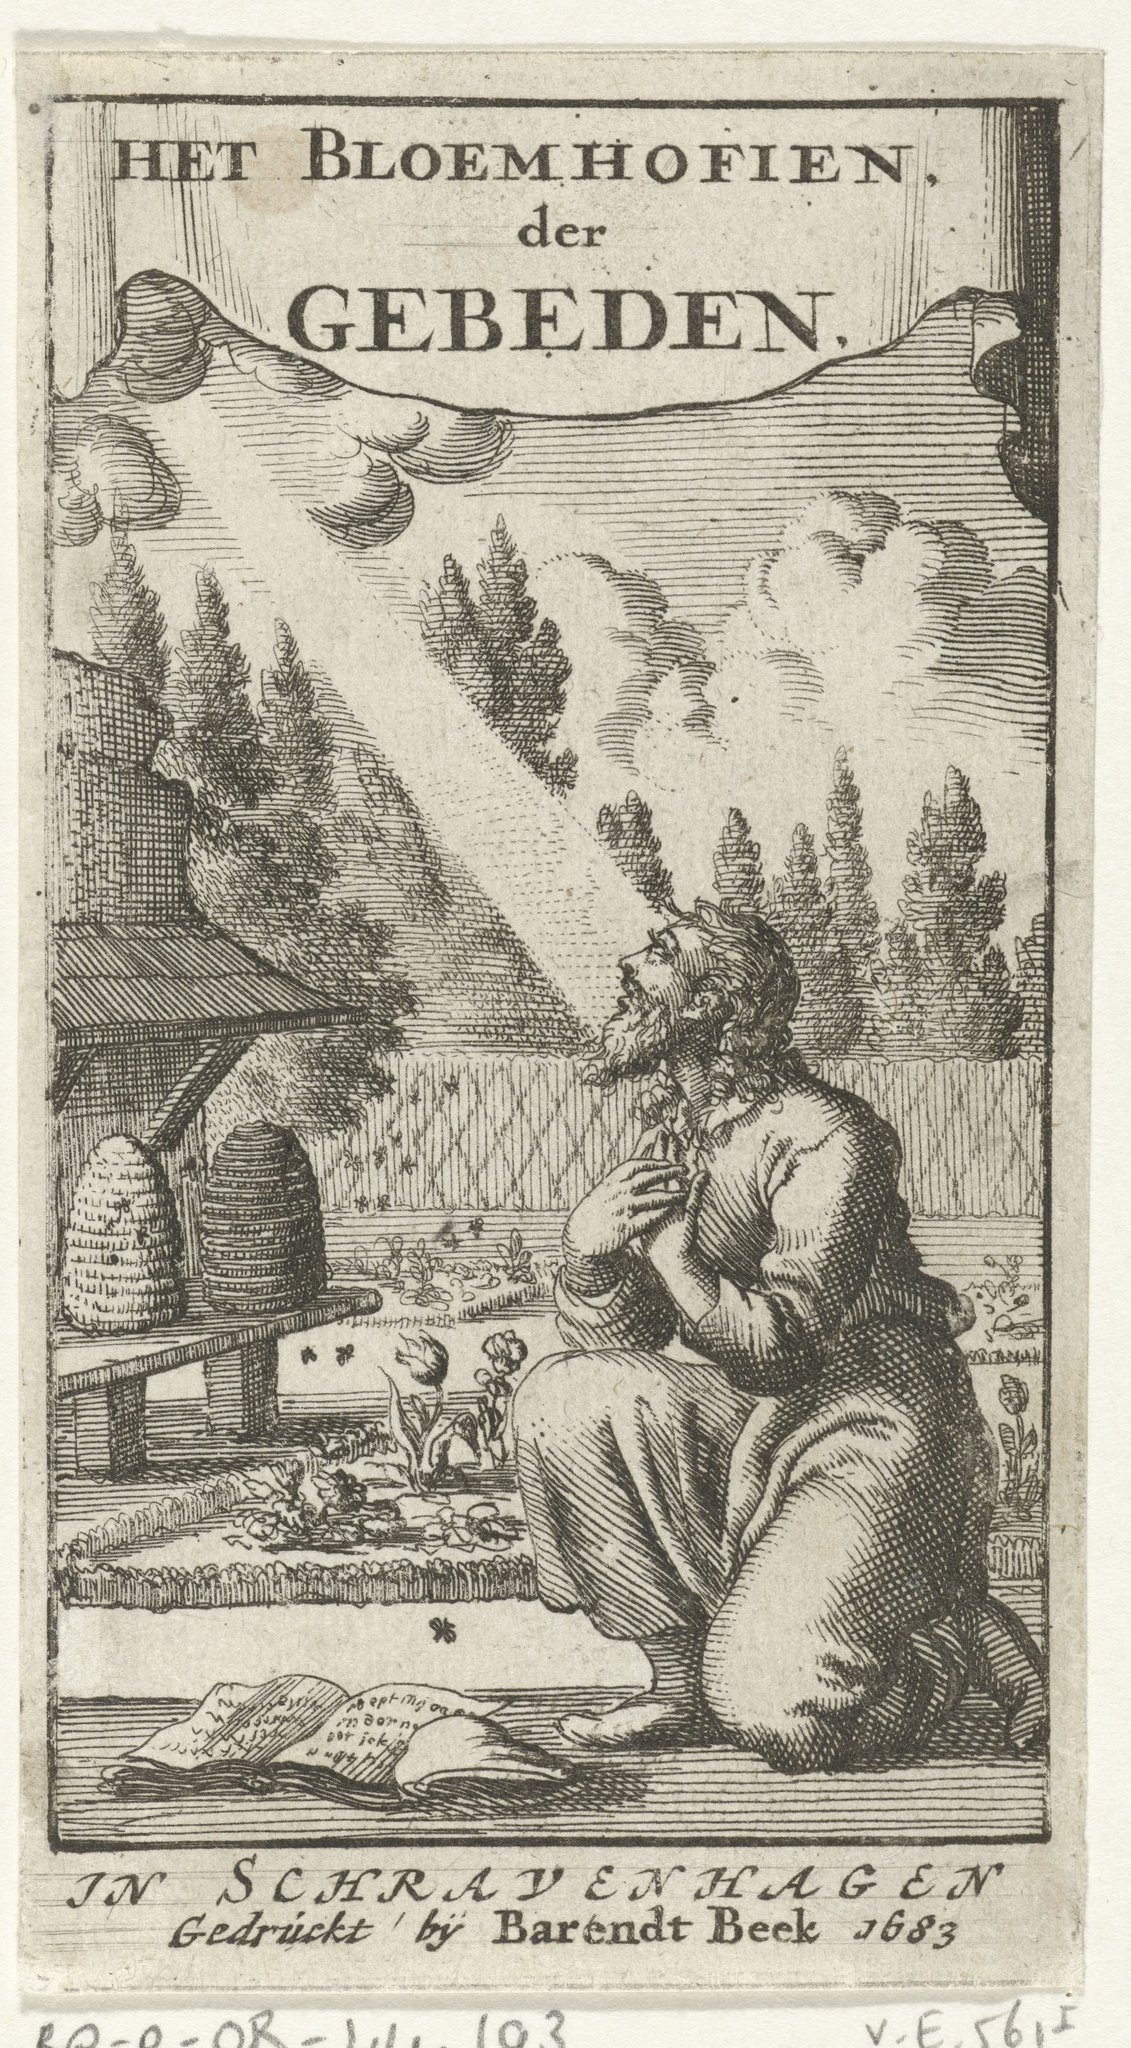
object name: print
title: Knielende man in een tuin door een bundel hemellicht beschenen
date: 1683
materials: paper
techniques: etching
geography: the hague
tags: garden, kneeling figure, light shining out of the heavens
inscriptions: collector's mark: Lugt 2228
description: Titelpagina voor: Feylingius, Johannes. Het bloem-hofje der gedighten, vervattende allerlye sinne-beelden, op goddelicke materien gepast. Den Haag: Barent Beeck, 1683.